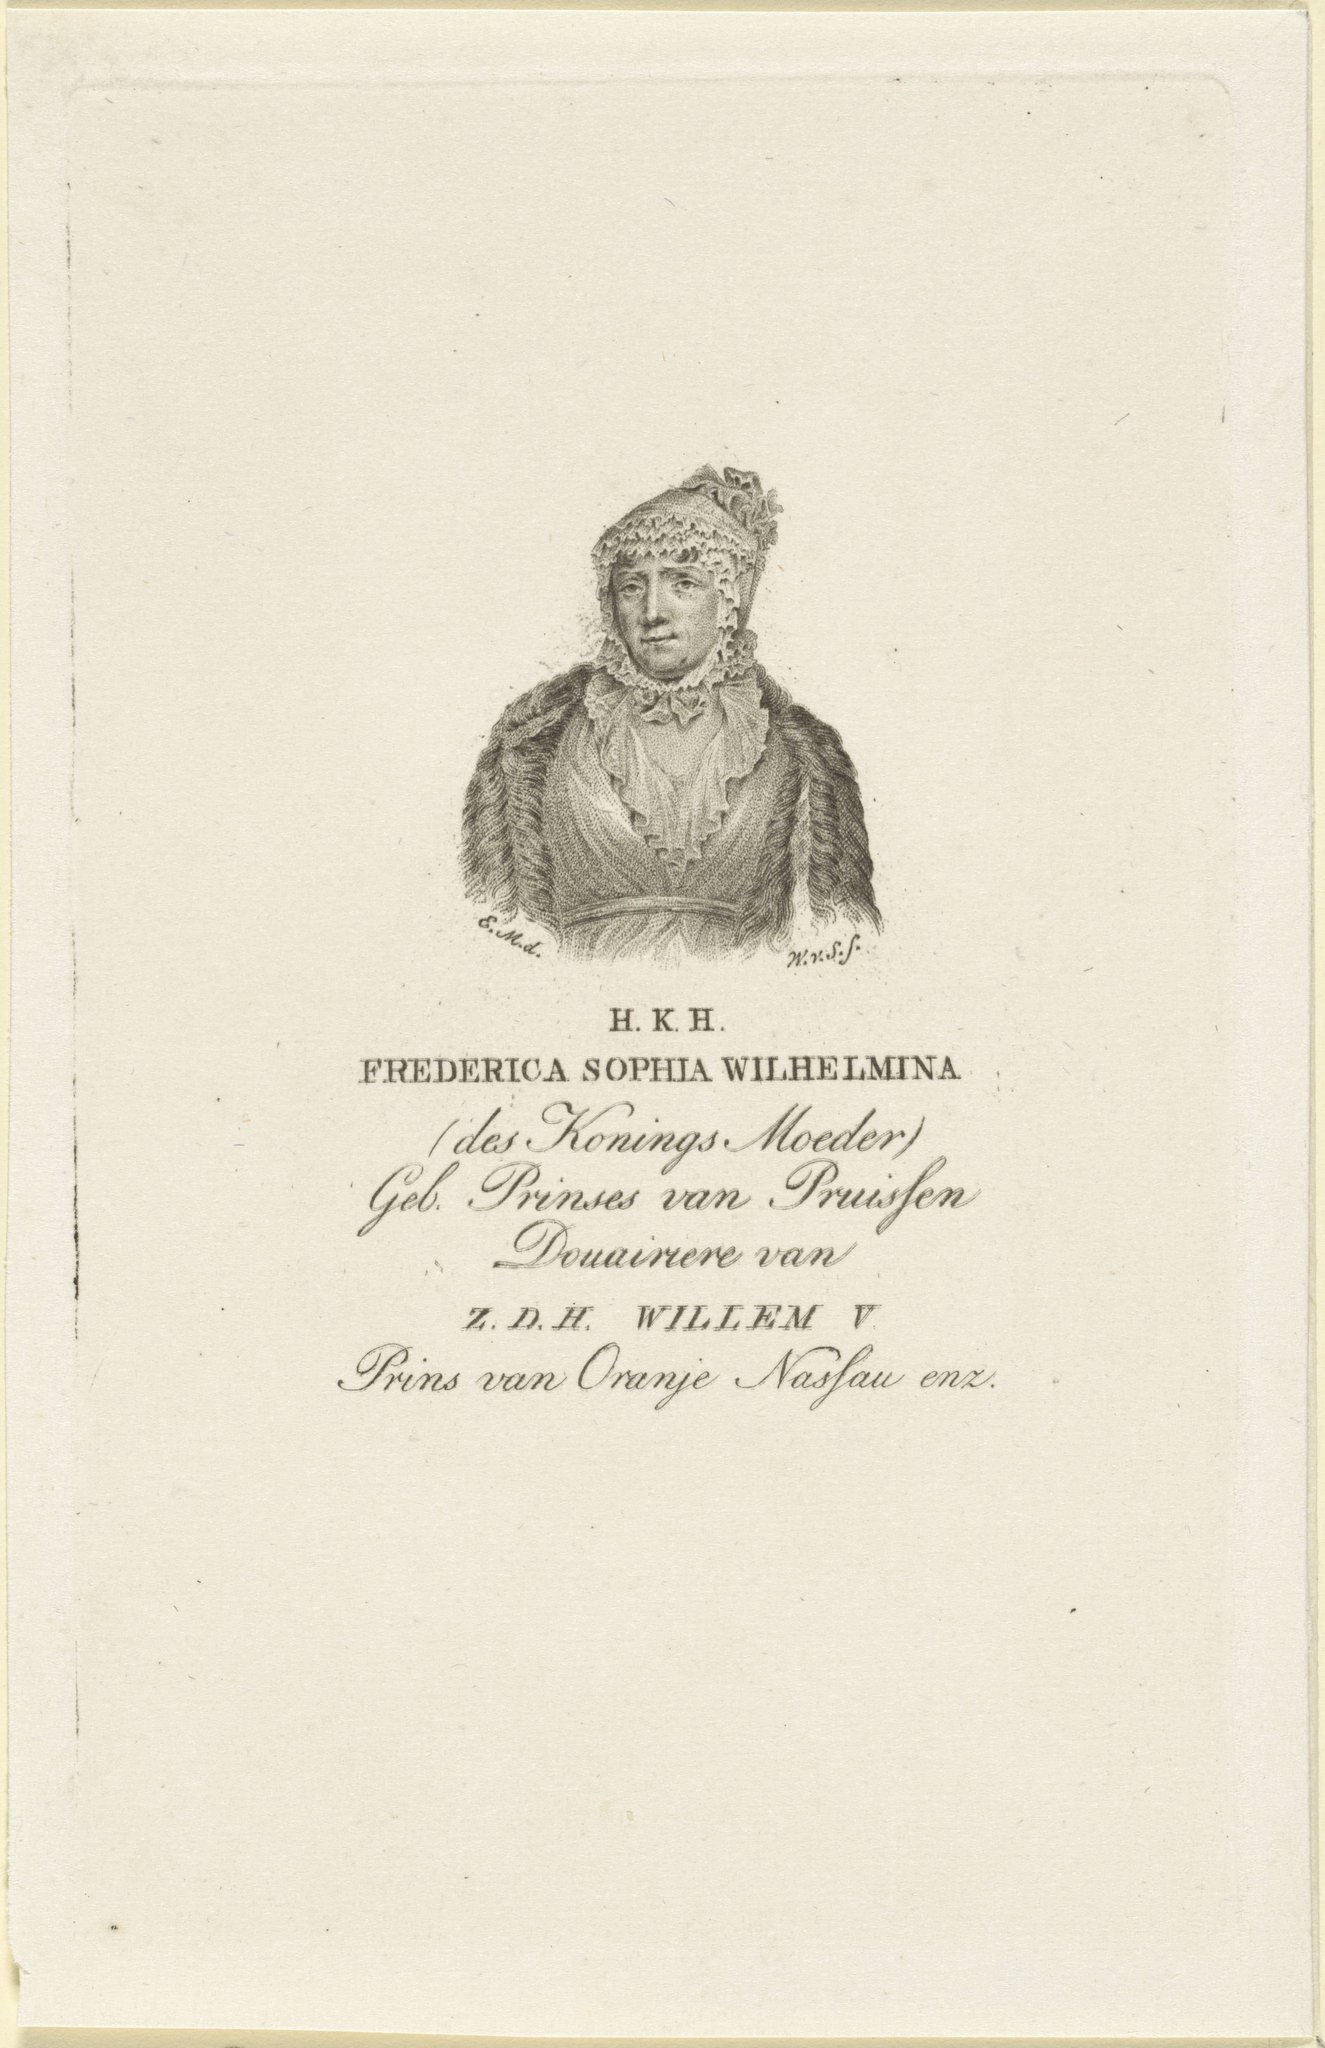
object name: print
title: Portret van Wilhelmina van Pruisen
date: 1815-1851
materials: paper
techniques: engraving, etching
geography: netherlands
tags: berlin, painter, draughtsman, wilhelmina of prussia (princess of orange)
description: Portret van Wilhelmina. In de ondermarge zeven regels Nederlandse tekst.